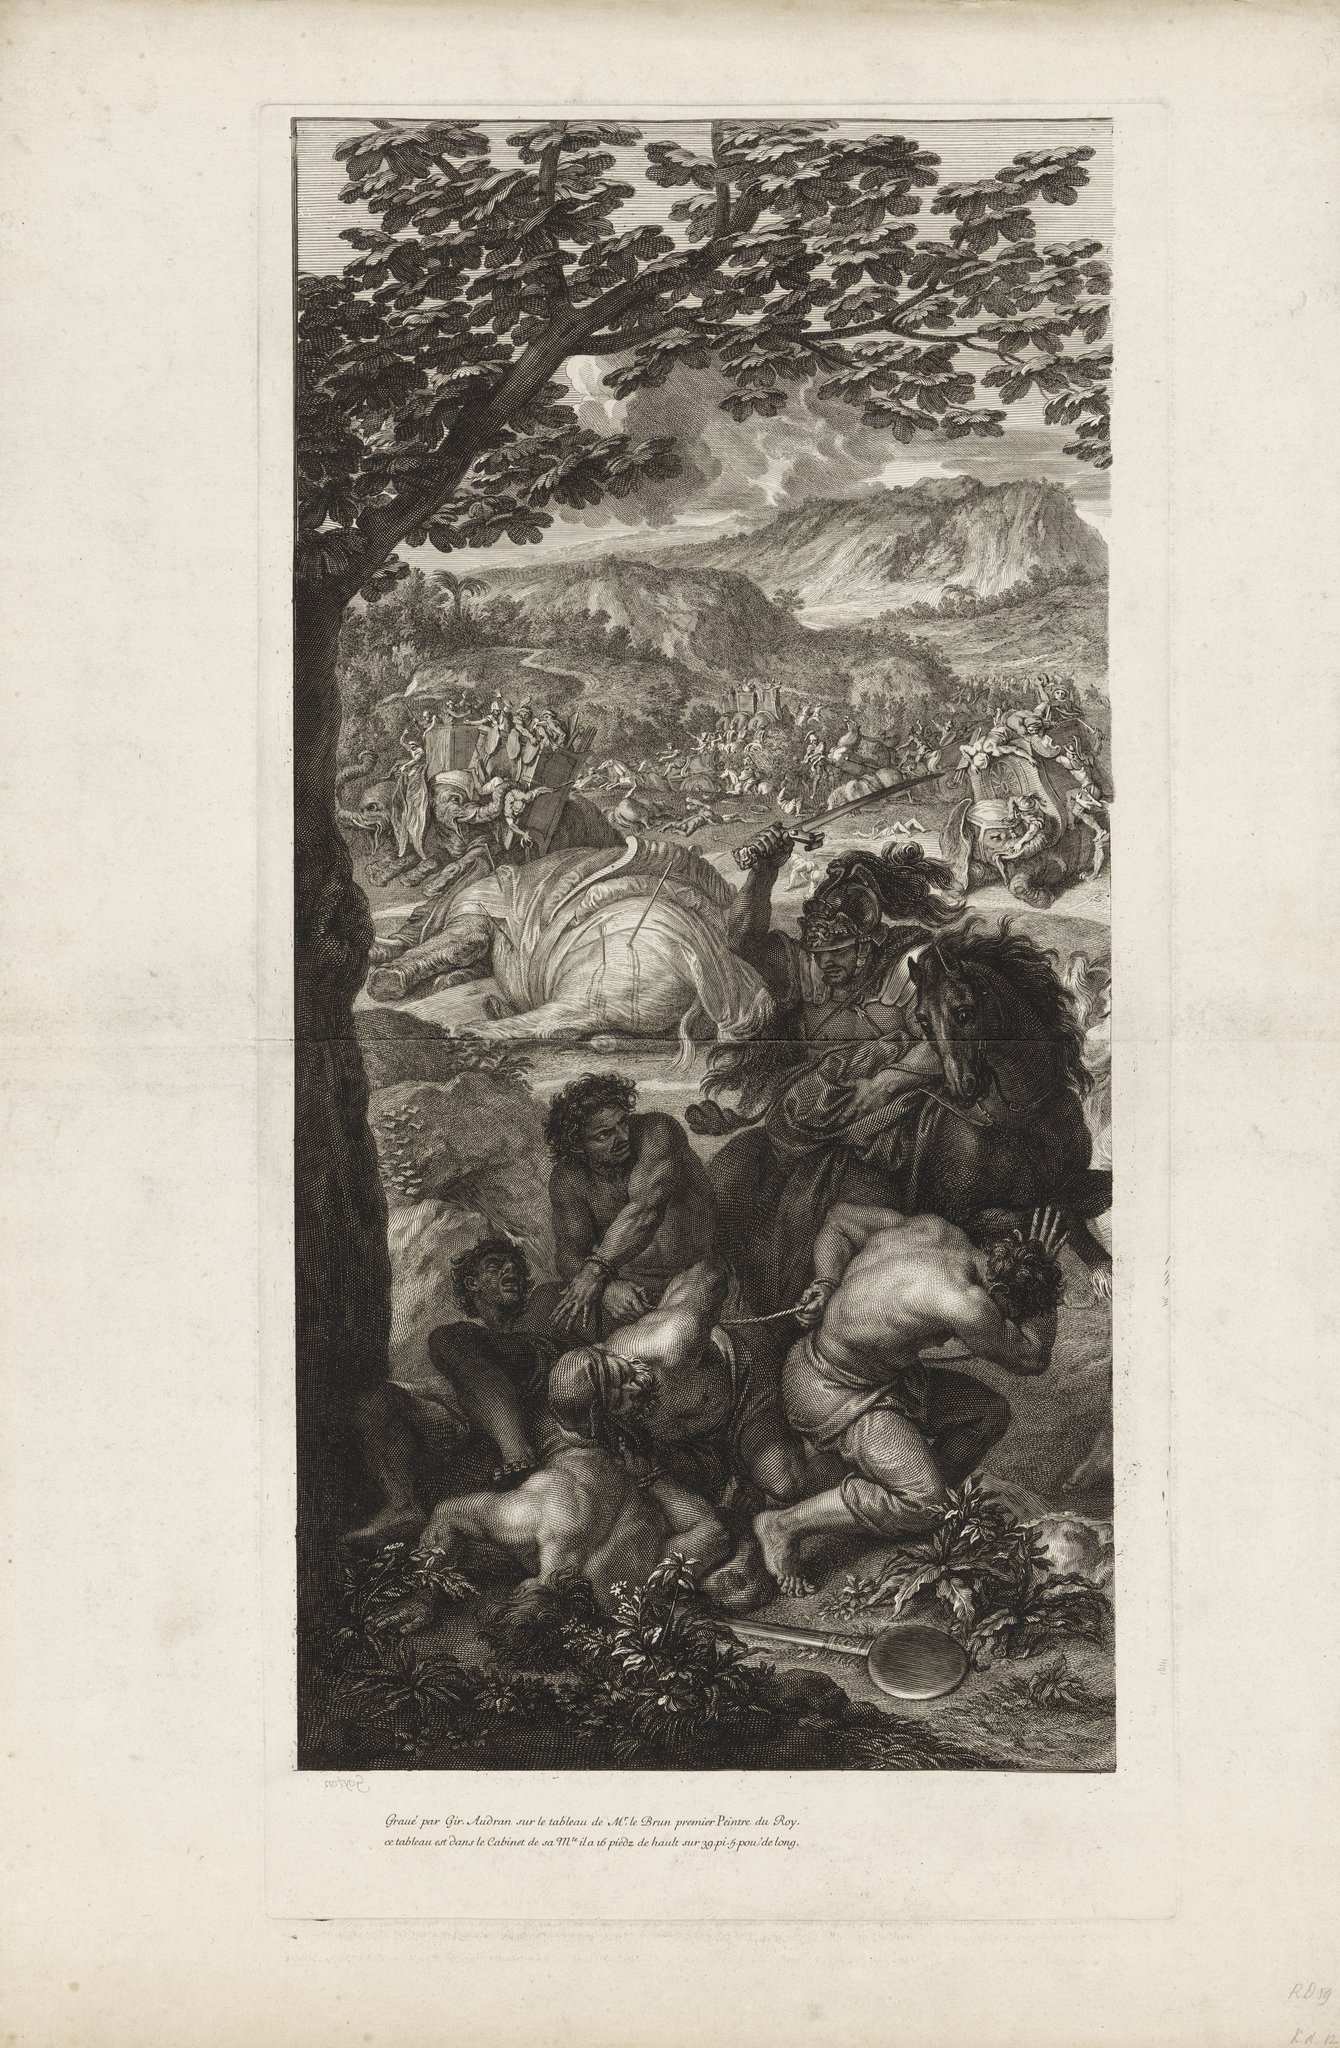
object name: print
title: Poros verwond in de strijd met Alexander de Grote (plaat 1)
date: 1678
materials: paper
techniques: engraving, etching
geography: paris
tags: the army of porus and its elephants are conquered by alexander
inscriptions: inscription: ‘Jd. 12’, inscription: ‘RD 59’, collector's mark: Lugt 1838, collector's mark: Lugt 240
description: Eerste blad (van links naar rechts) van een prent gedrukt van vier platen.